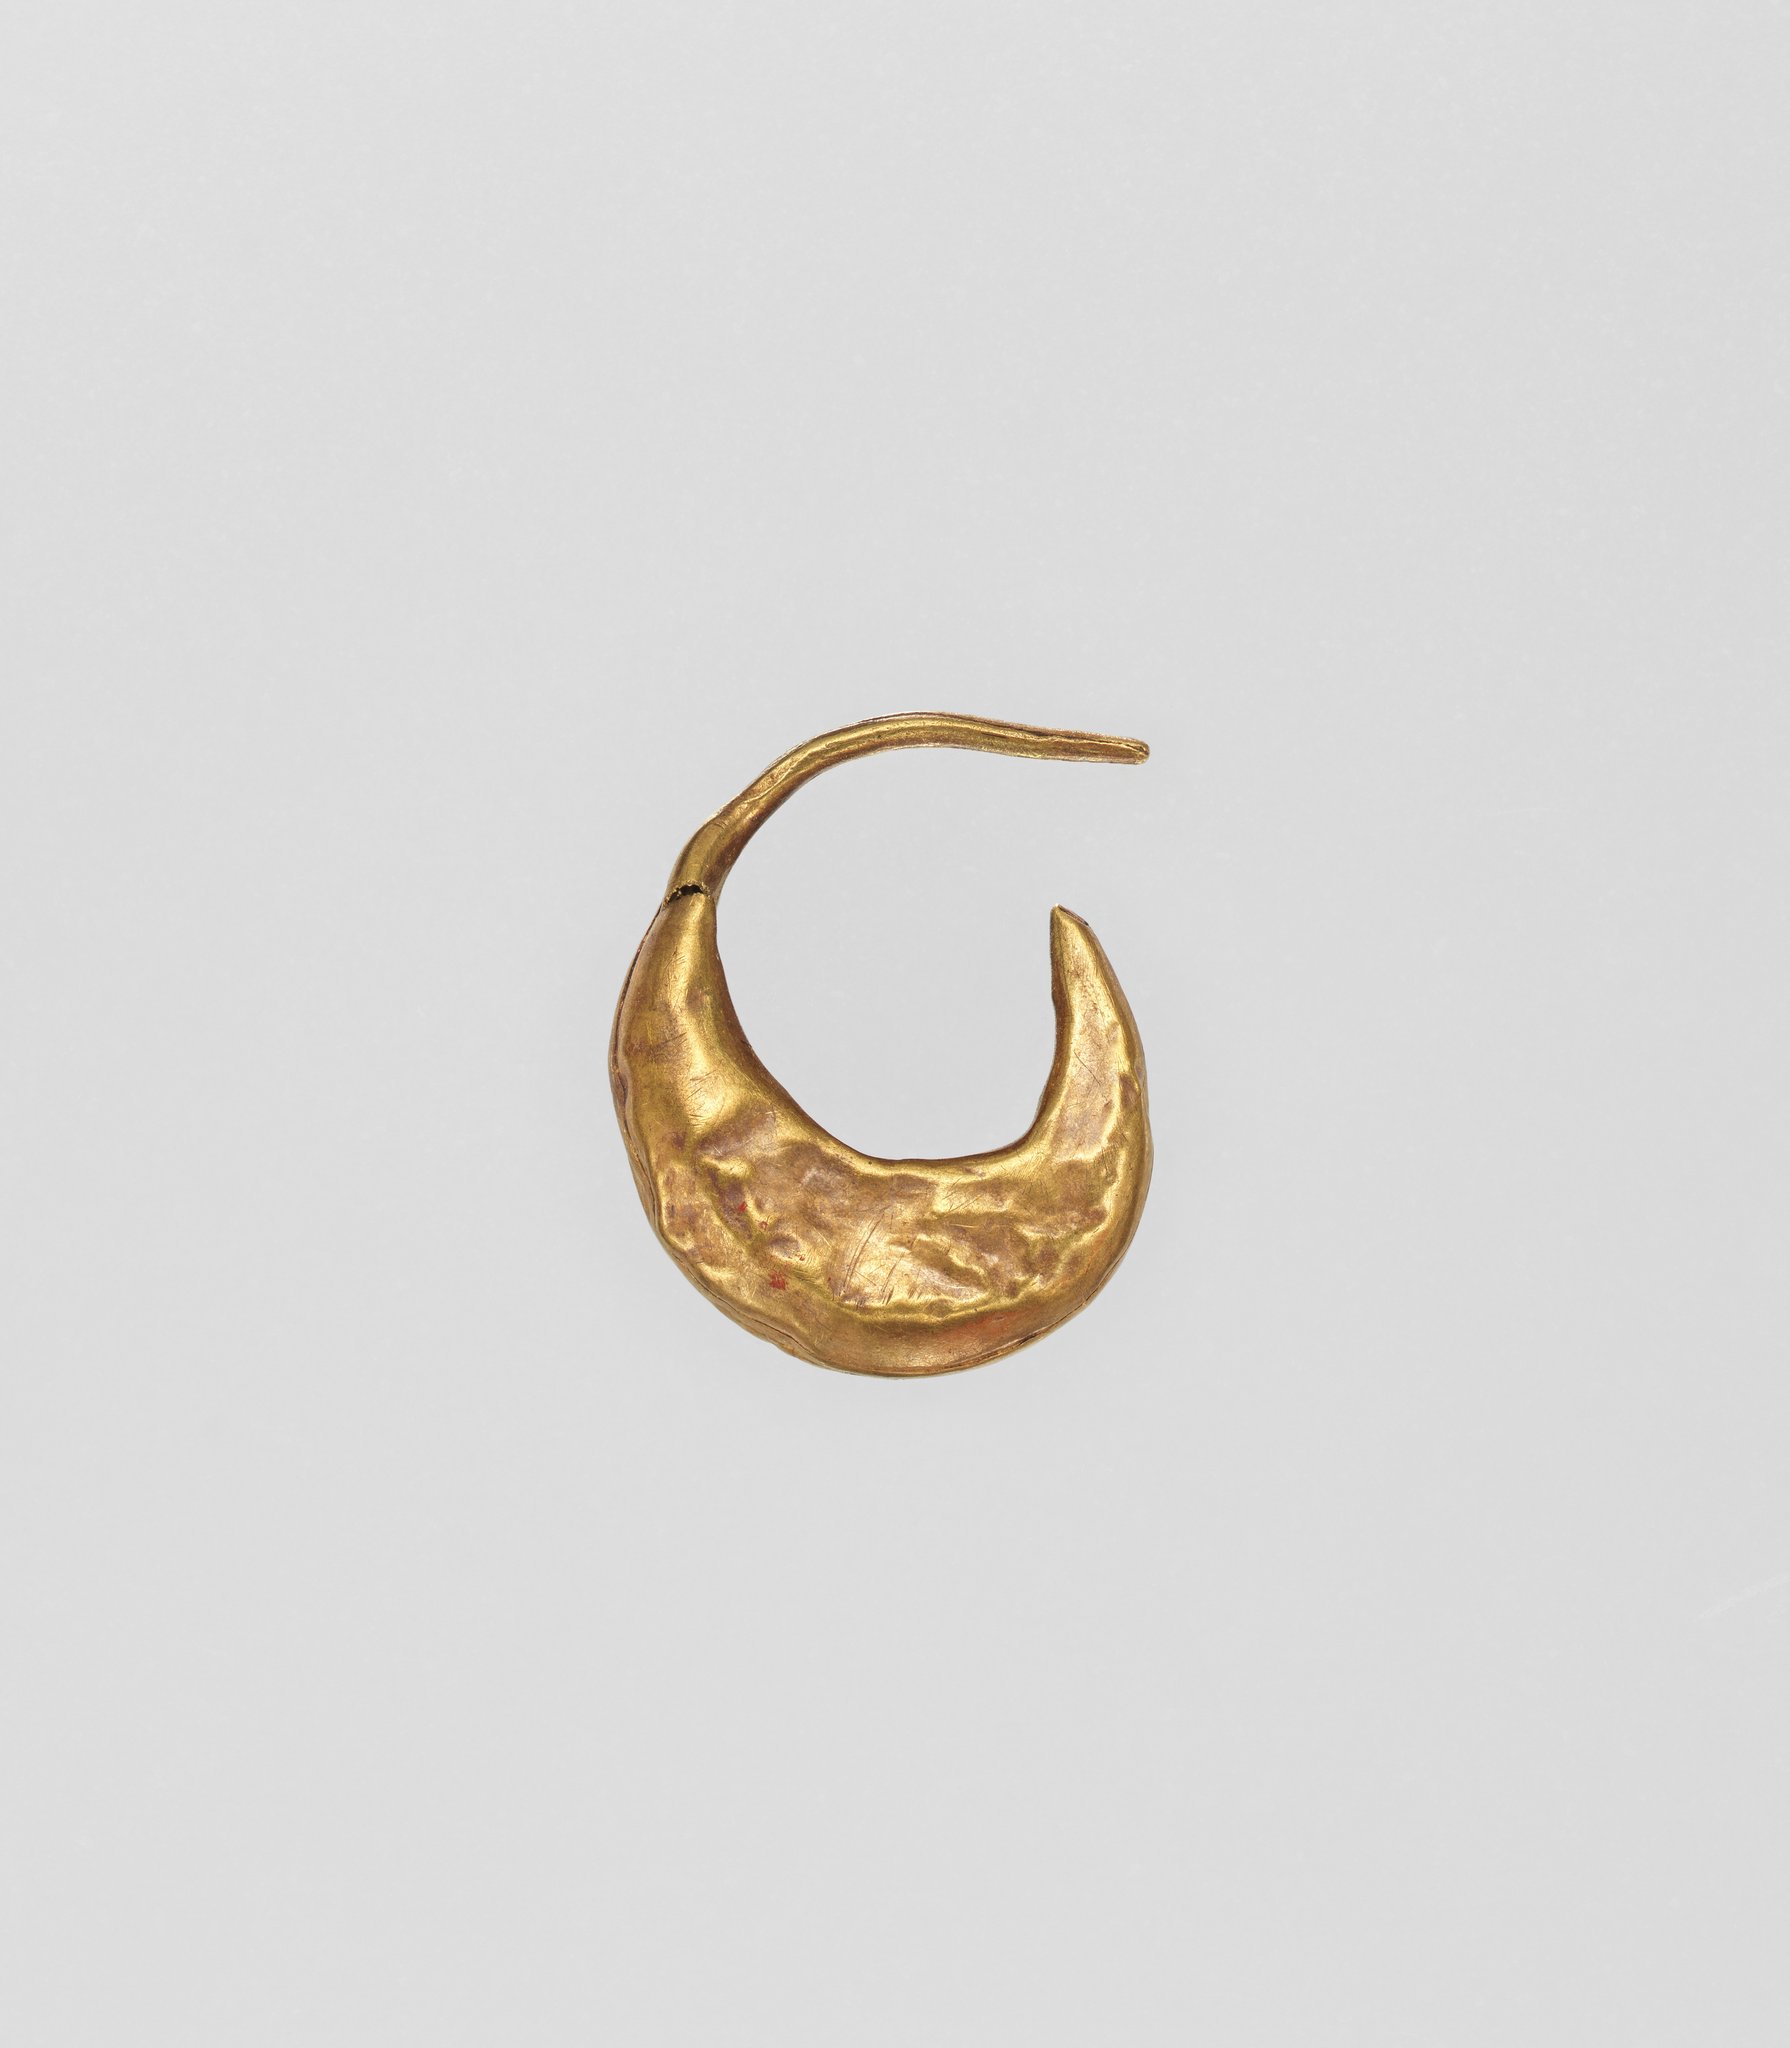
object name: earring, from cat mummy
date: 332-330 BCE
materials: gold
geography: egypt